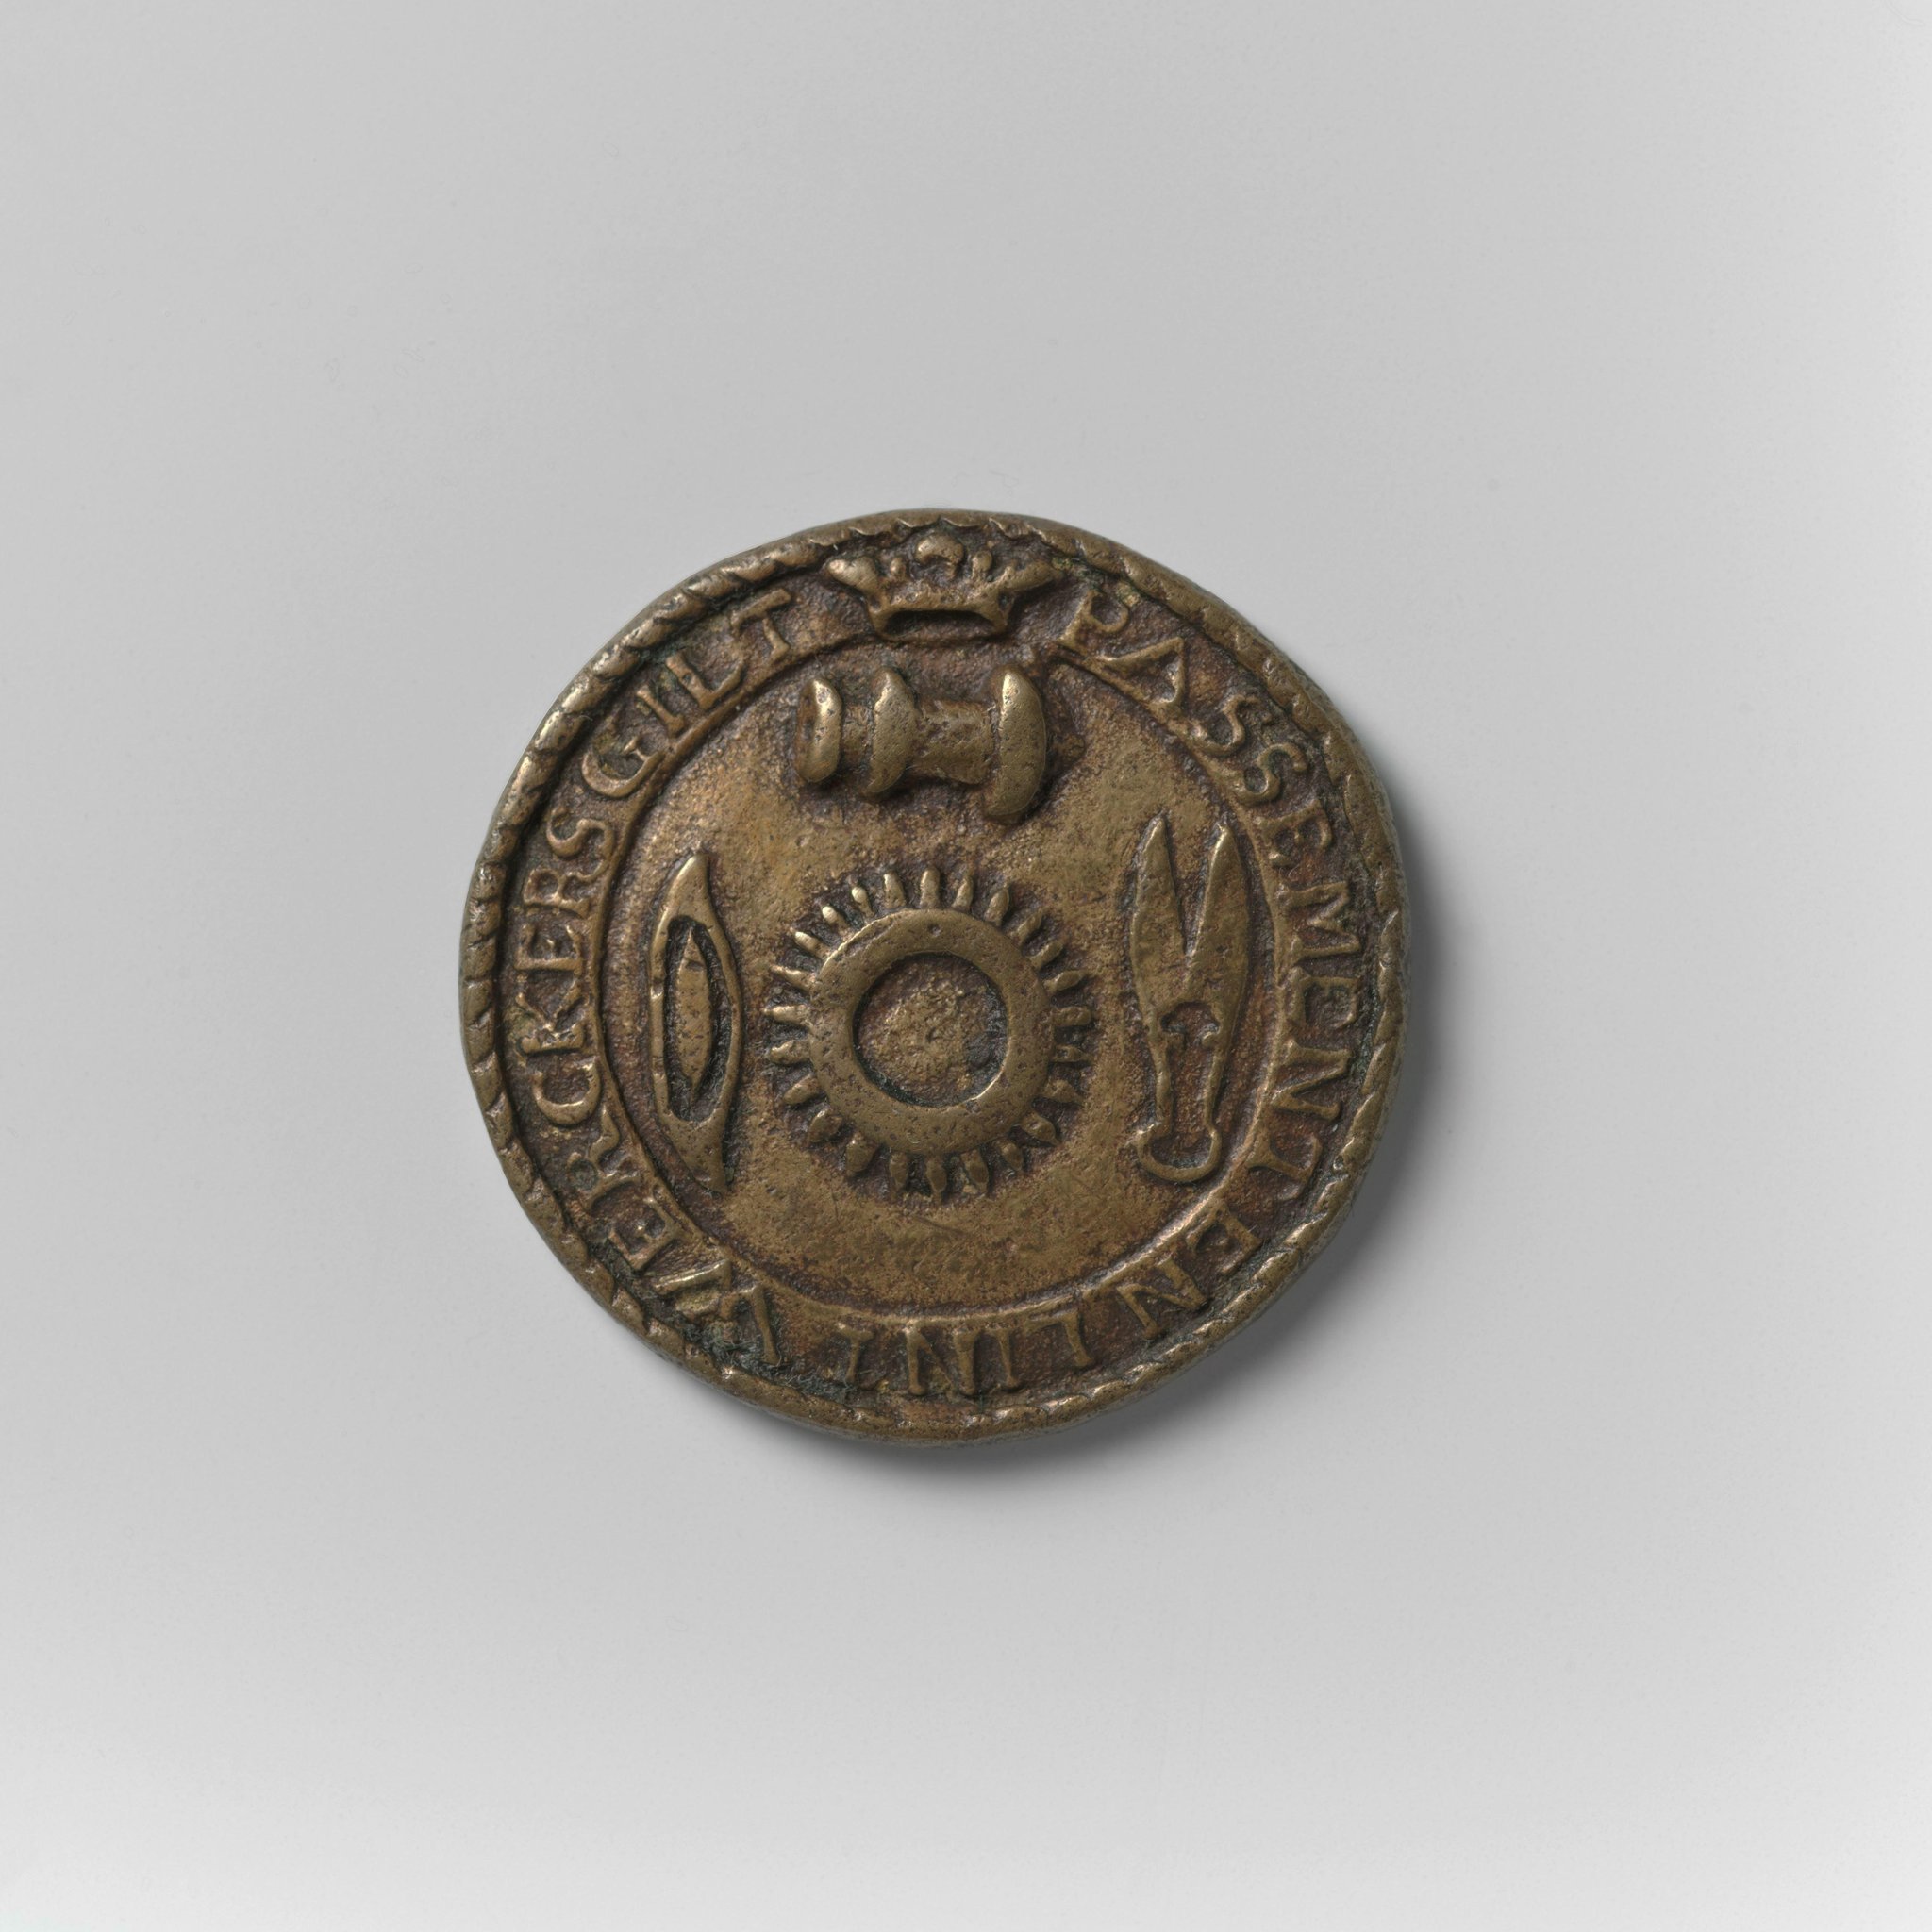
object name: medal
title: Presentiepenning van het Passement- en Lintwerkersgilde te Amsterdam, 1705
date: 1705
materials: brass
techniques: casting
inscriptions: circumscription: ‘PASSEMENT EN LINTWERKERS GILT’, inscription: ‘Iacob Tomasz’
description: Gegoten messing penning, op de voorzijde een klos, spoel, haspel en schaar onder een kroon, met omschrift, op de keerzijde een gekroond wapenschild Amsterdam met dragers boven een inscriptieruimte, op naam van Jacob Tomasz